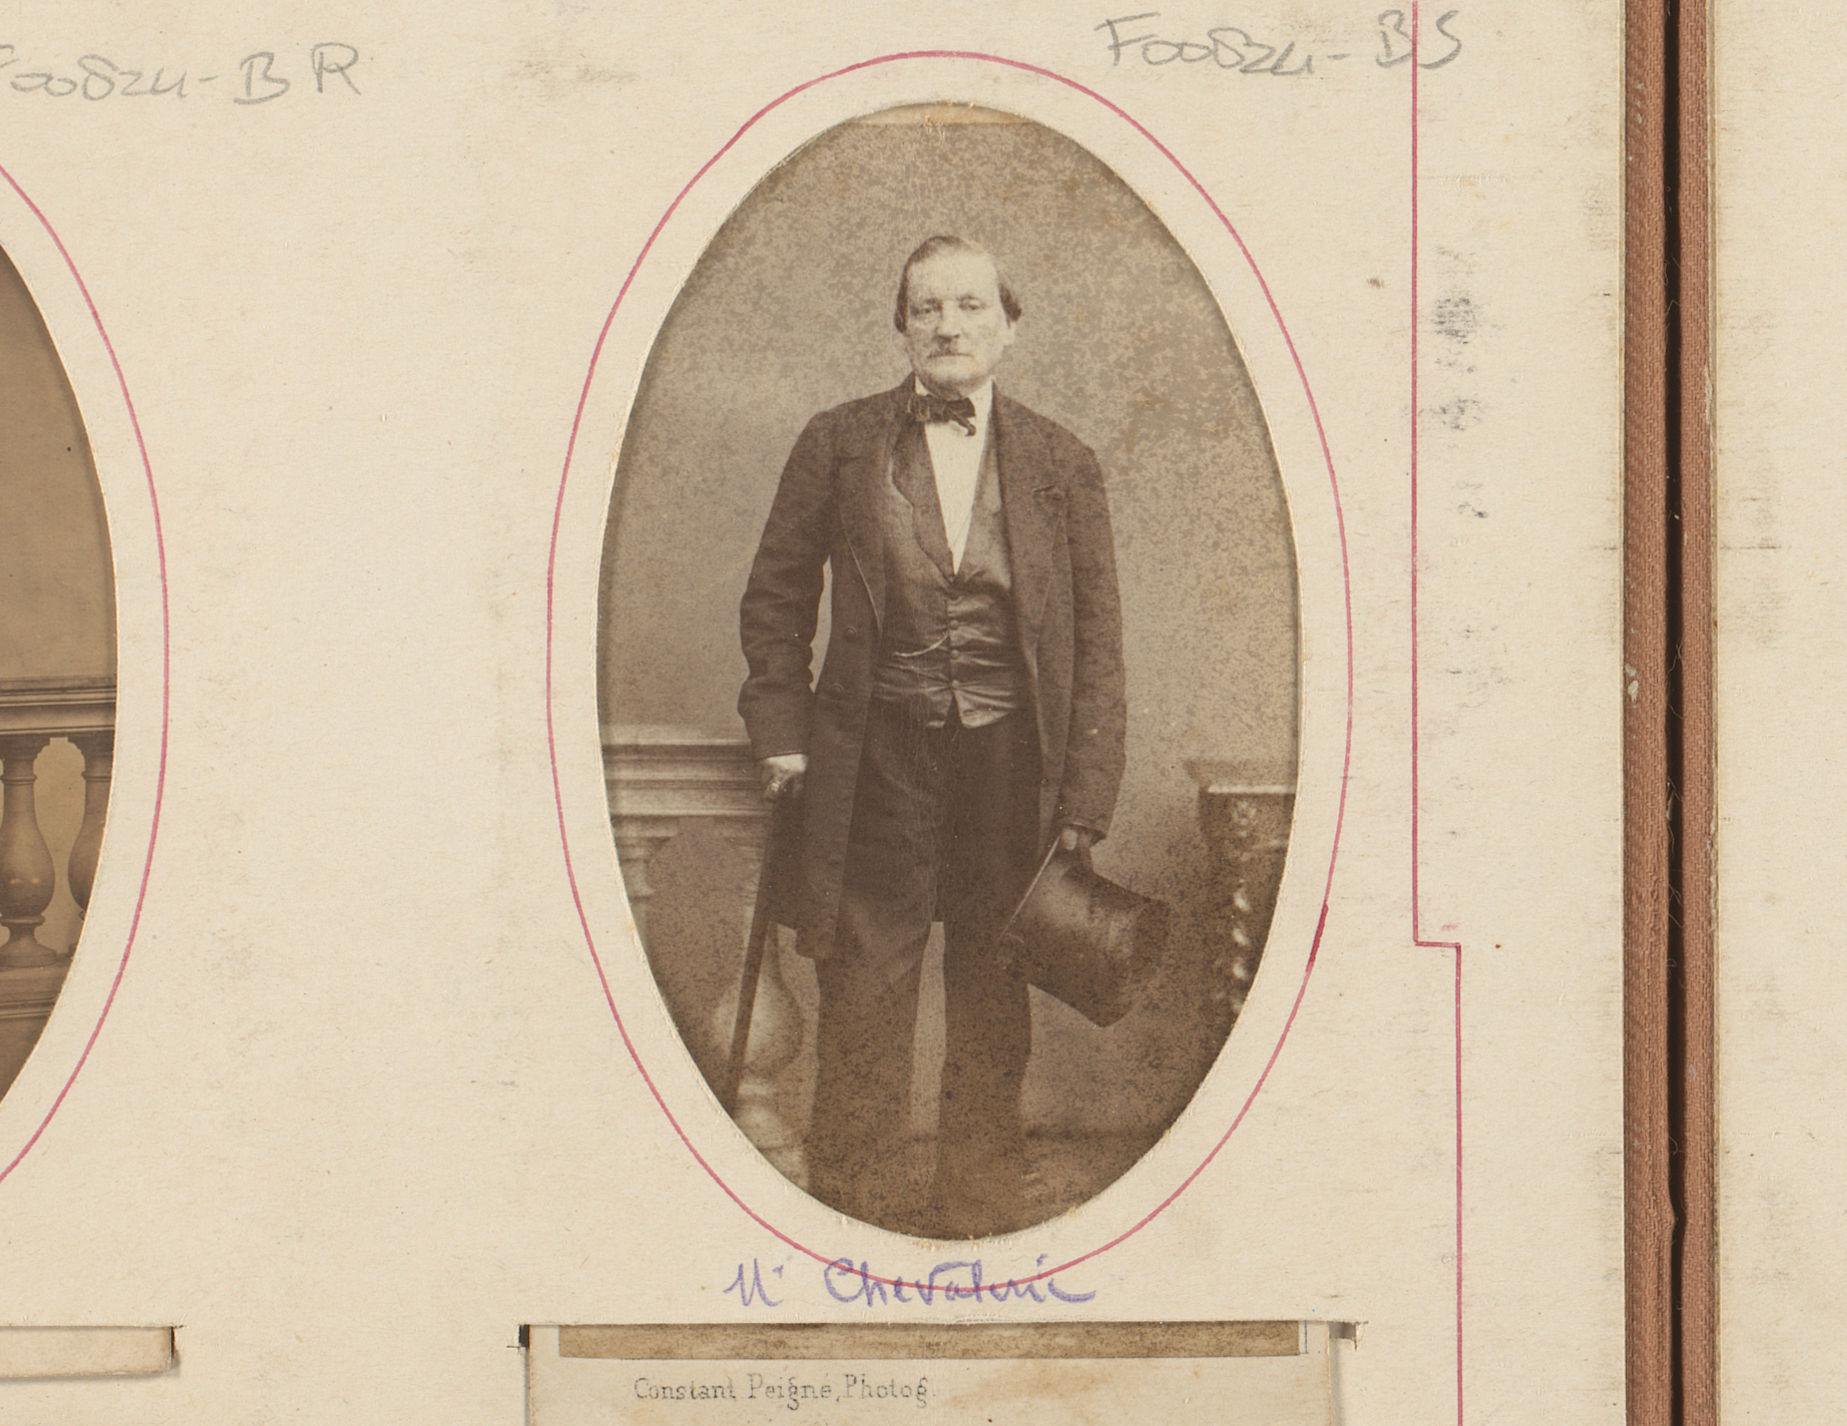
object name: album leaf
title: Portret van een man, aangeduid als Mr. Chevalerie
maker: constant peigné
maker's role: fotograaf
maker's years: 1834-1916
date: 1861-1868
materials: cardboard, paper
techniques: albumen print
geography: nantes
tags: adult man, anonymous historical person portrayed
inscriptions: inscription: ‘Breveté, S.G.D.G./ Elève de Mr.-BOUSSETON,/ Peintre Photographe,/ de S.M. la Reine d'Espagne,/ de la Maison de l'Empereur, etc..’, address: ‘40, Rue Contrescarpe, 40./ (Près la Place Bretagne)./ NANTES.’